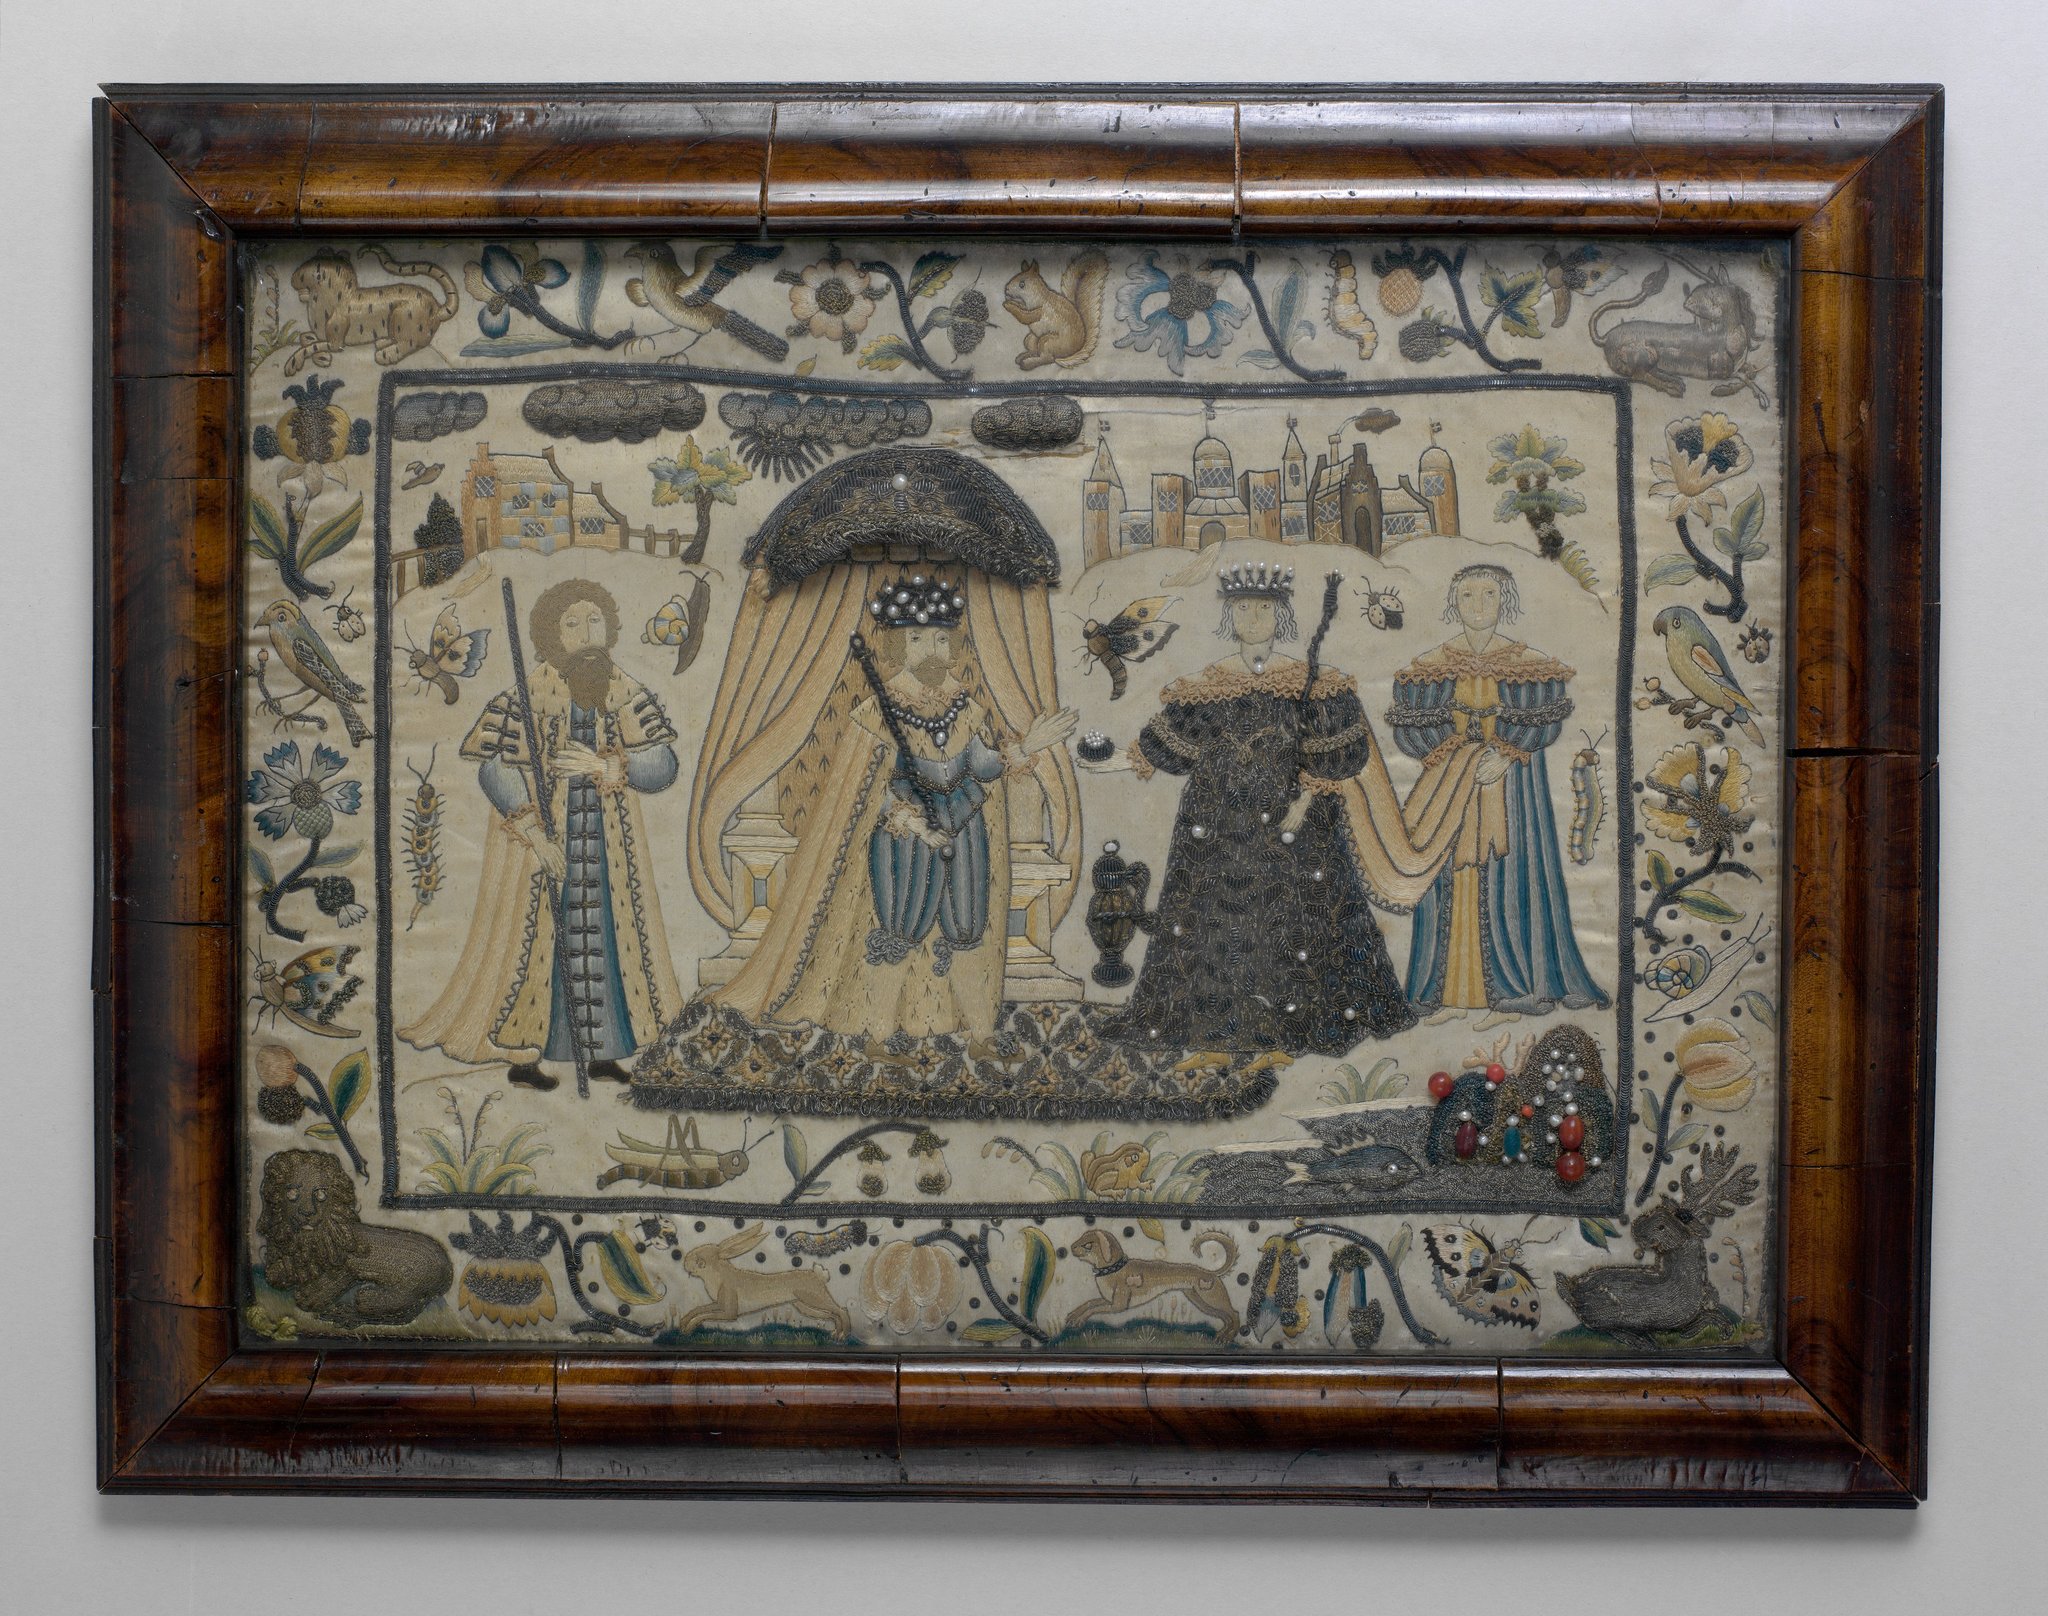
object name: embroidered picture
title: Picture with stumpwork embroidery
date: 1601-1700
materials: metal thread, pearl, silk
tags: birds,men,insects,lions